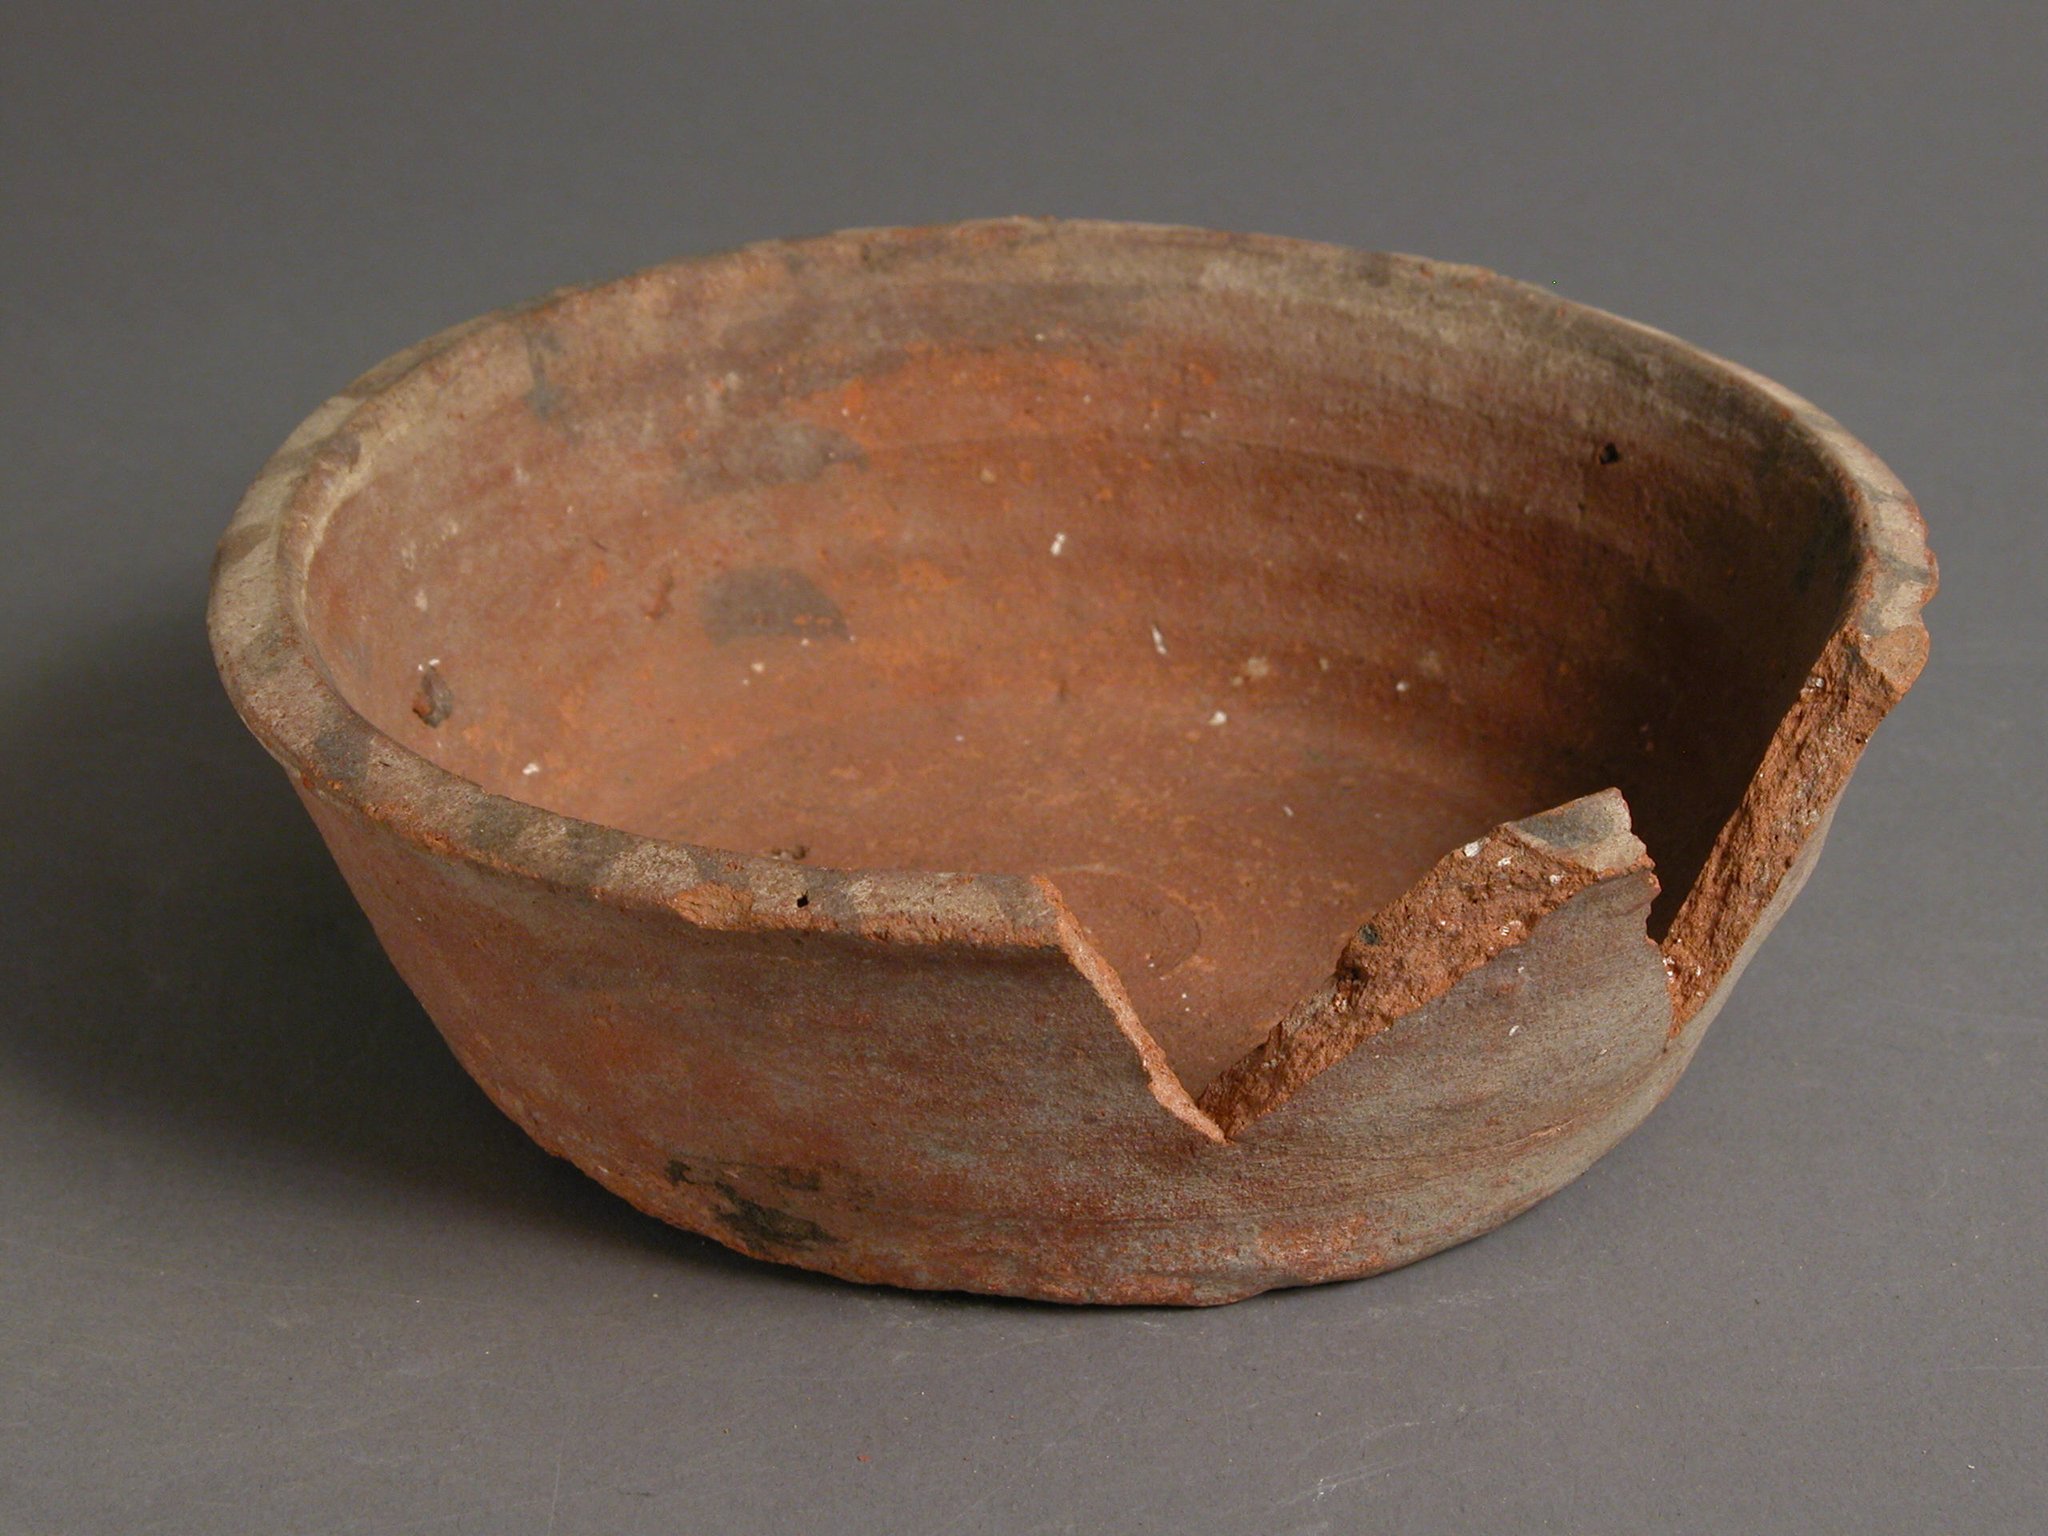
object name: bowl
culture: coptic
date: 301-700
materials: earthenware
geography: egypt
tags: bowls